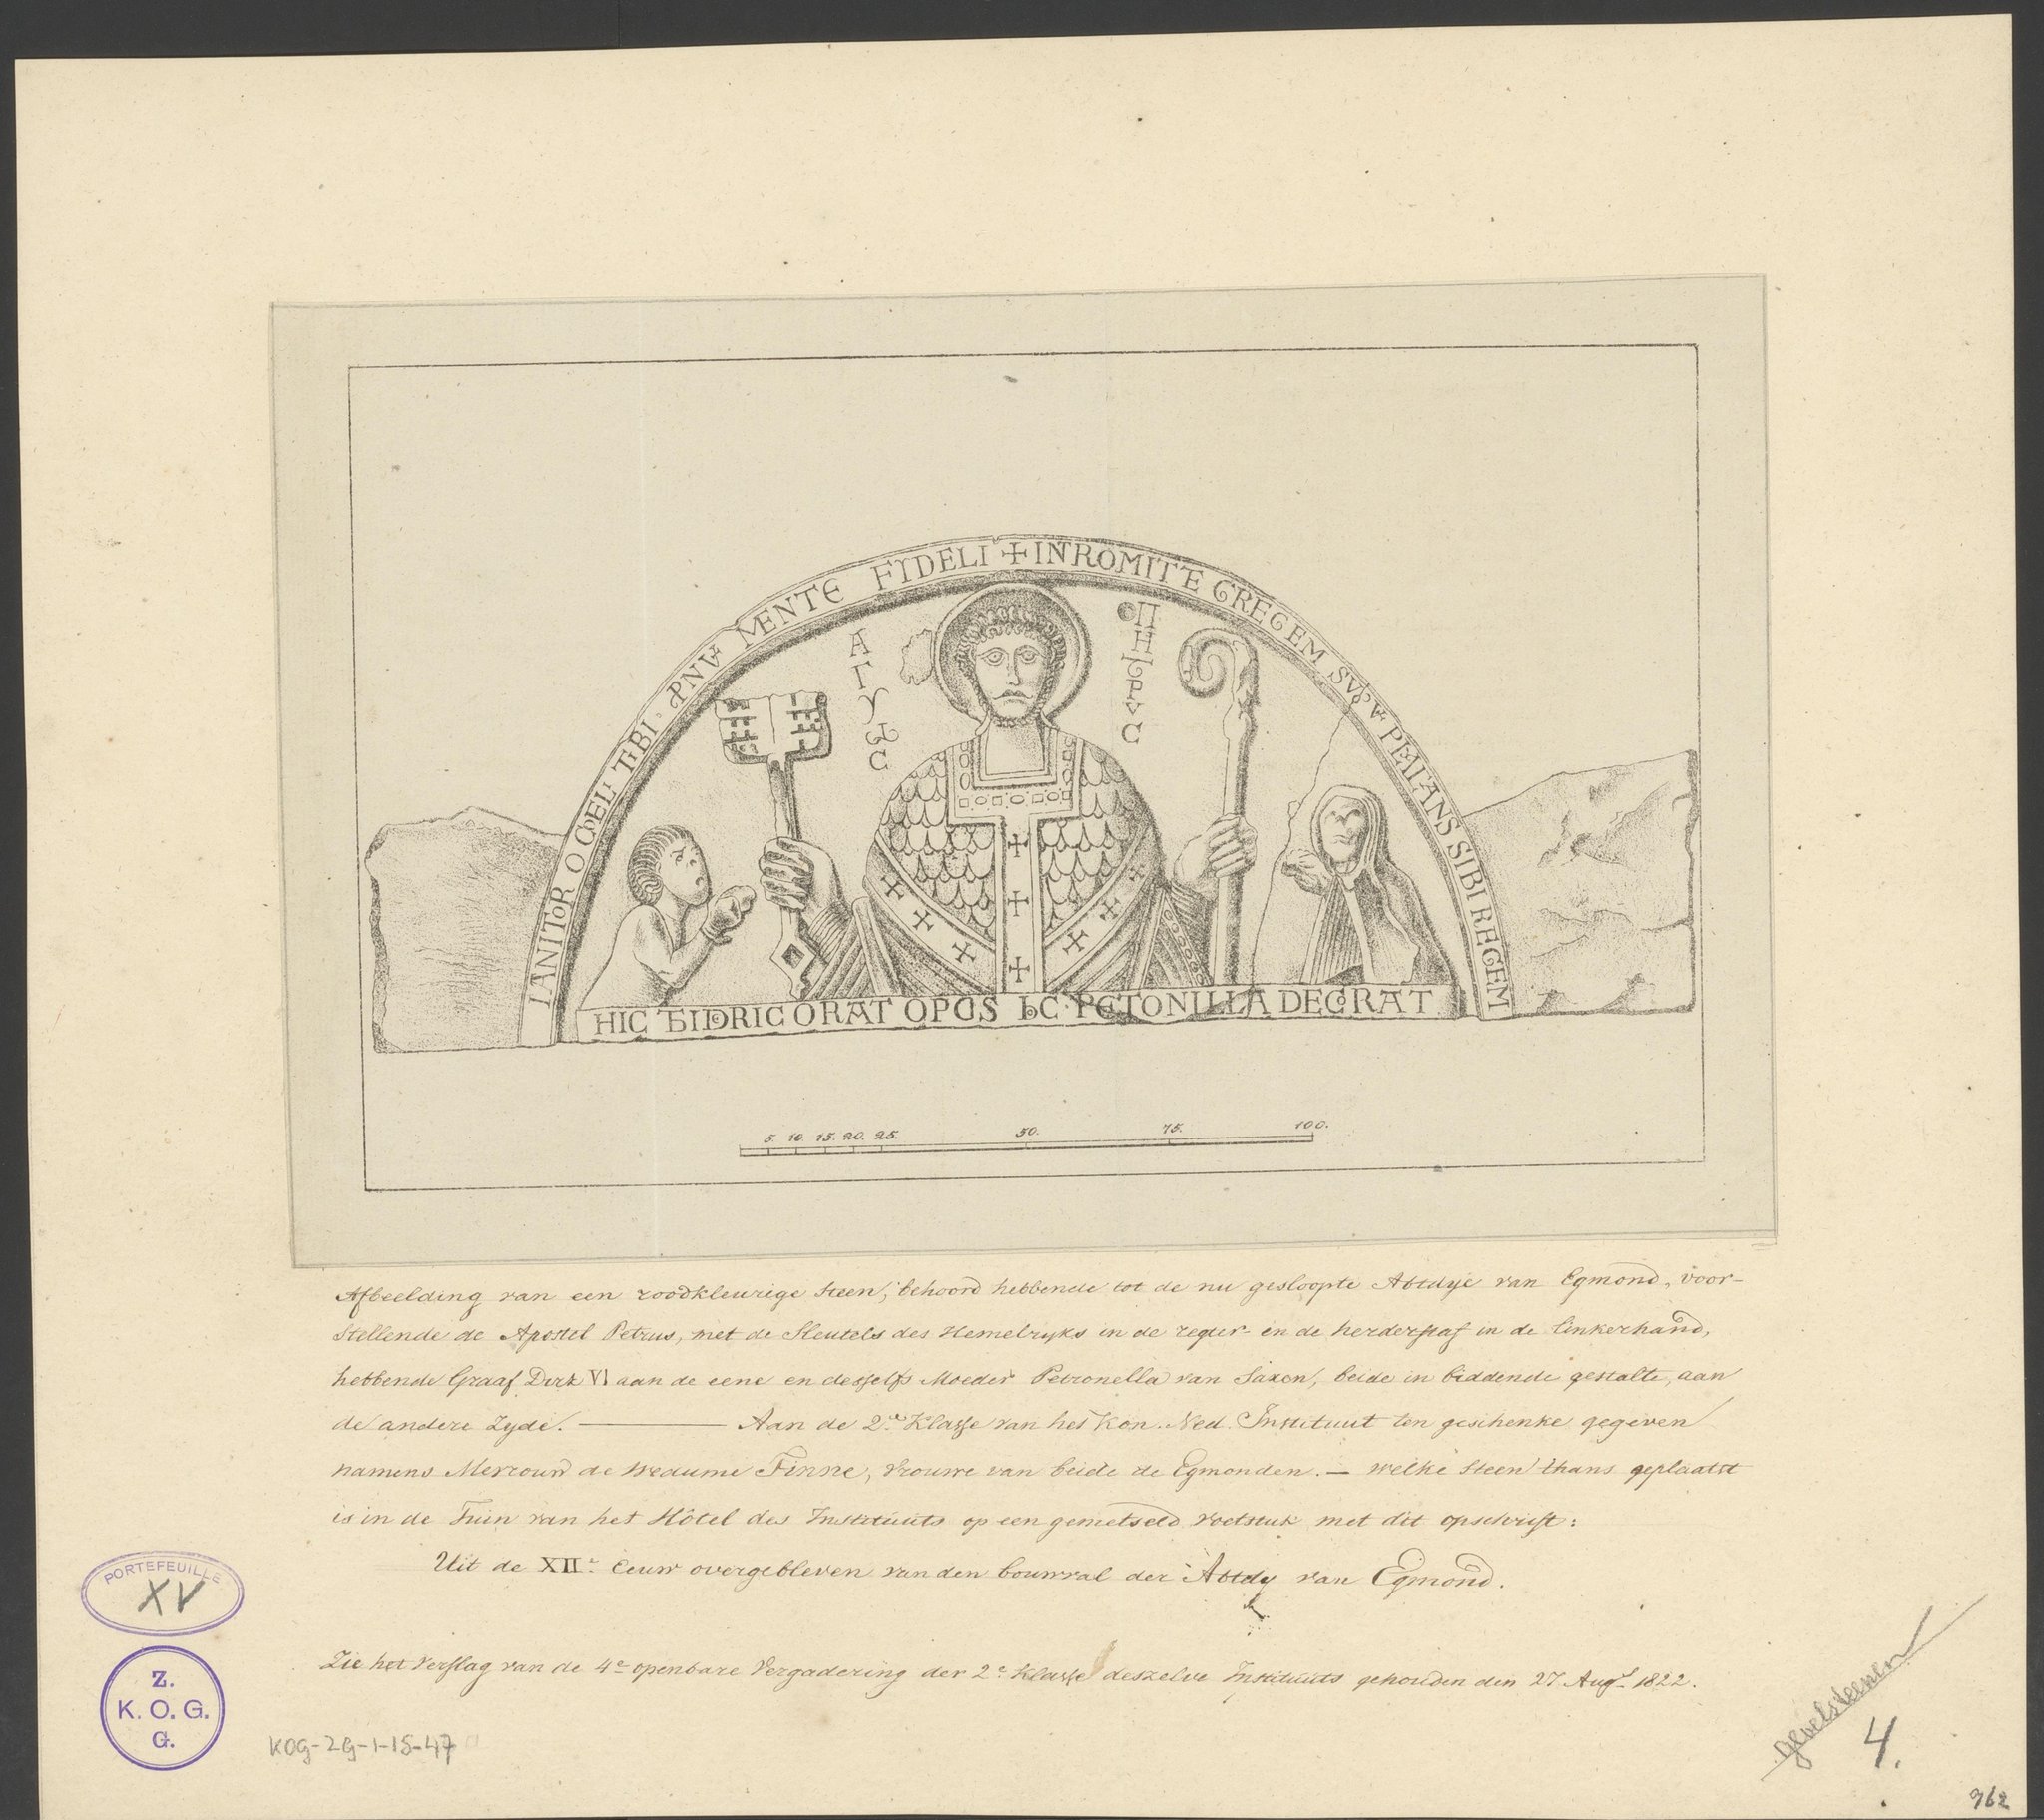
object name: print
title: Gevelsteen met Petrus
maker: Anonymous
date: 1800-1822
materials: paper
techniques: lithograph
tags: the apostle peter, first bishop of rome; possible attributes: book, cock, (upturned) cross, (triple) crozier, fish, key, scroll, ship, tiara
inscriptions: collector's mark: Lugt 1641, stamp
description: Rode gevelsteen behorende tot de gesloopte abdij van Egmond. In het midden de apostel Petrus met een sleutel en herdersstaf. Onderwerpsrubrieken binnen de Atlas Zeden en Gewoonten: Handel, nijverheid en verkeer, Uithangteekens, gevelstenen.